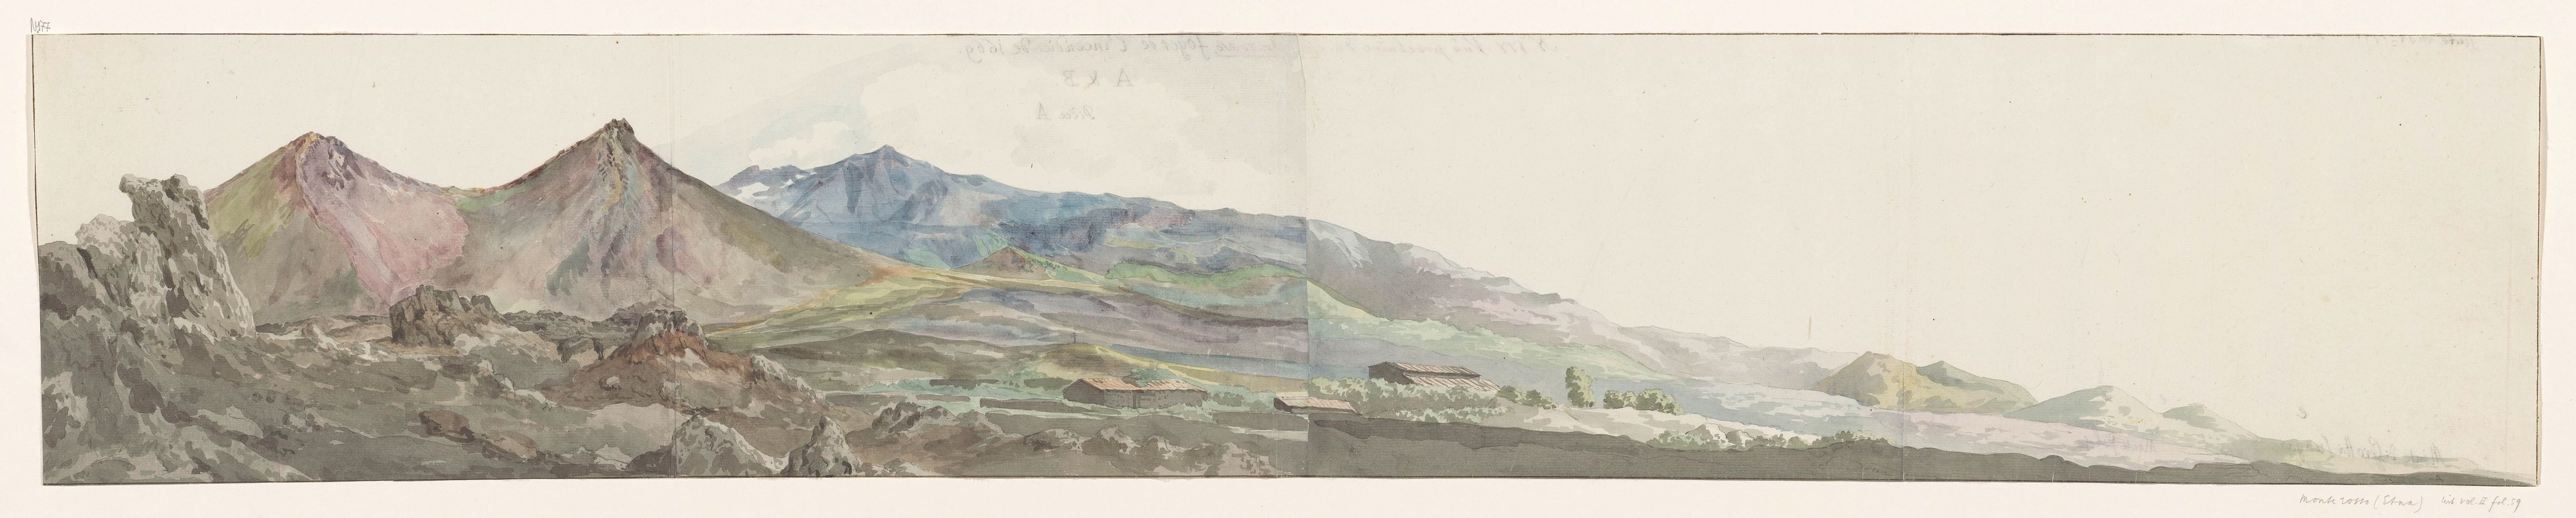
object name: drawing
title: Brandhaard van vulkaanuitbarsting in 1669 gelegen naast Monte Rosso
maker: louis ducros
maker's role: draughtsman, print maker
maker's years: 1748-1810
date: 1778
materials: chalk, paper, watercolor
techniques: brush, pen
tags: volcano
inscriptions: inscription: ‘No 177A-B Vue prochaine du Monte-Rosso foyer de l'incendie de 1669’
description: Tekening uit het album 'Voyage en Italie, en Sicile et à Malte', 1778.